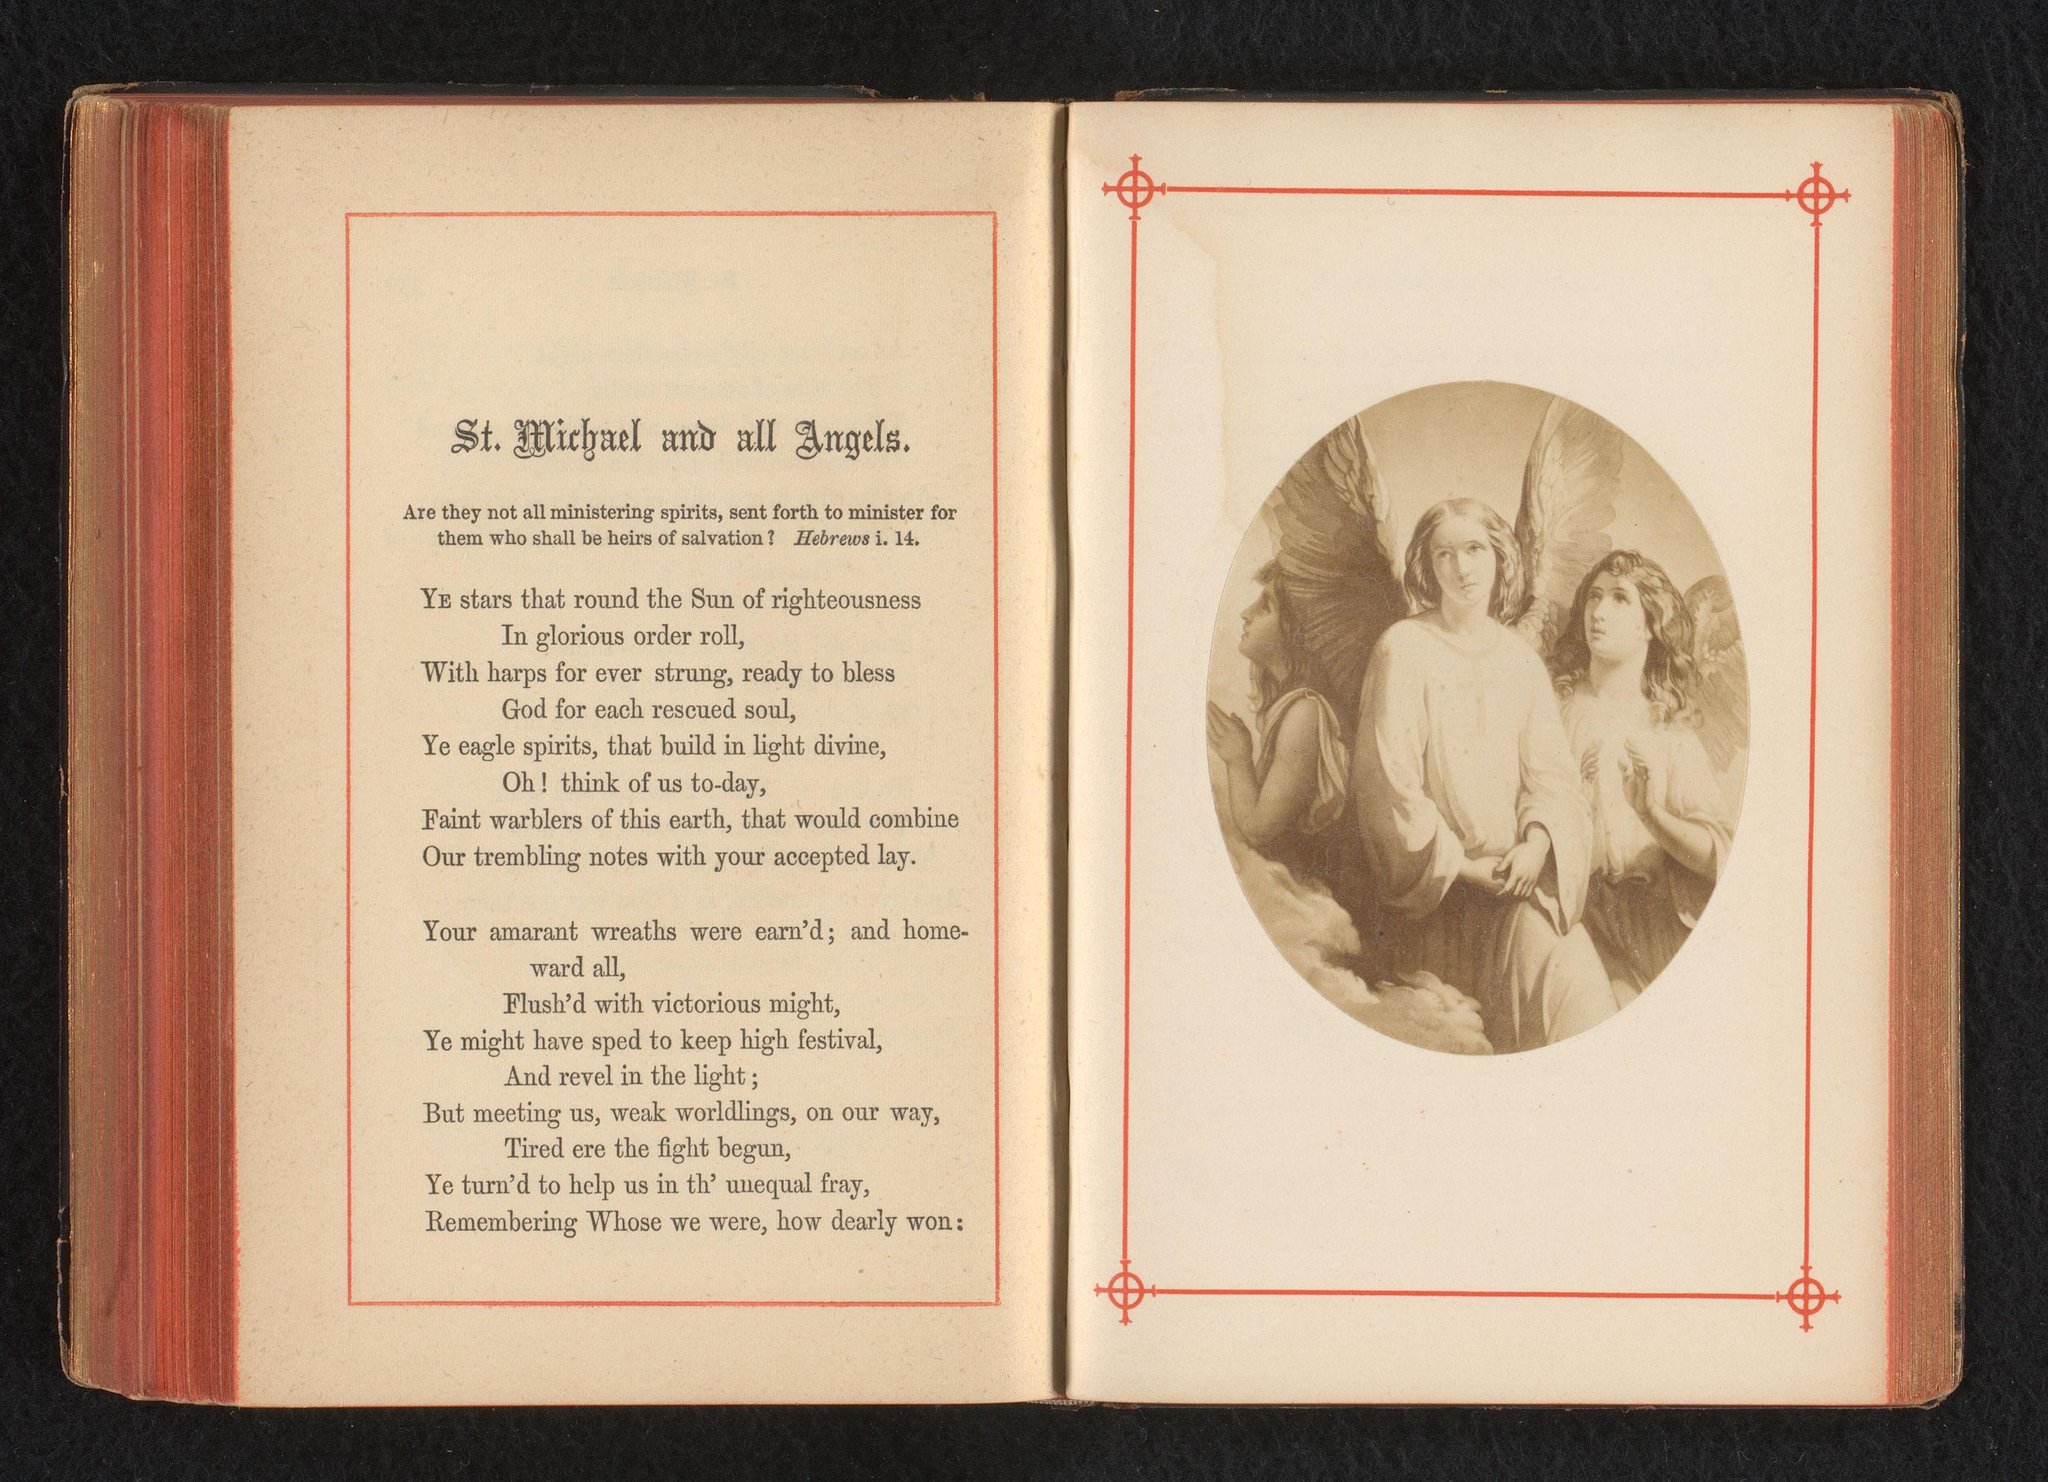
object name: page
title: Fotoreproductie van een schilderij van aartsengel Michaël en andere engelen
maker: Anonymous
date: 1861-1866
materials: paper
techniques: albumen print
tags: the archangel michael (often in armour with sword or lance)